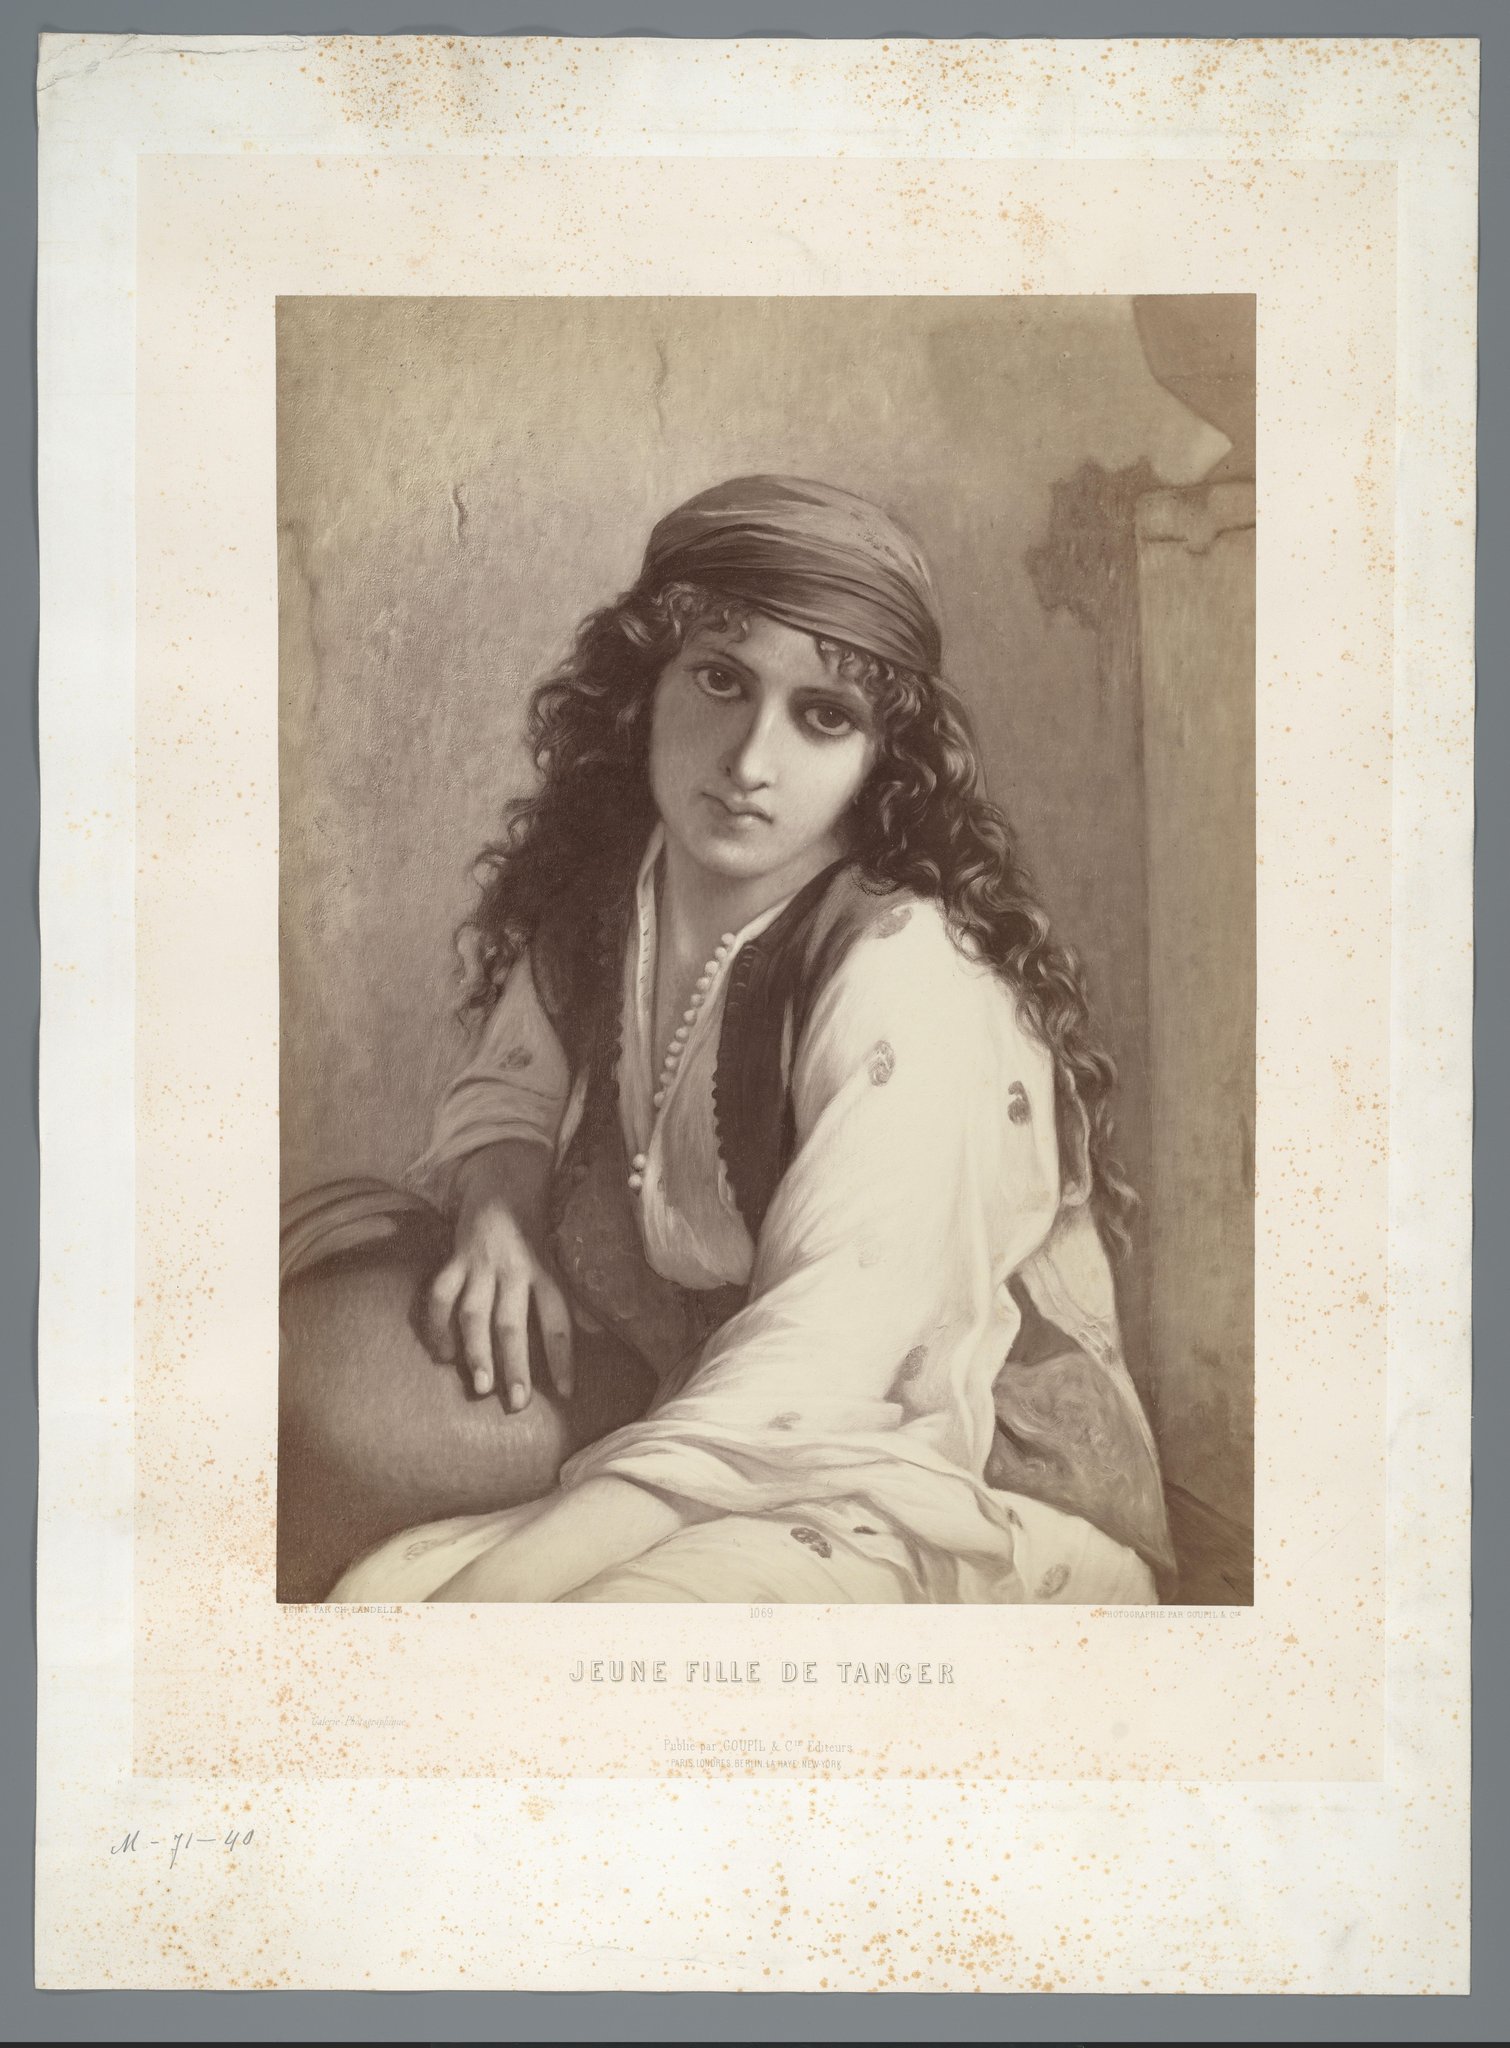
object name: reproduction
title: Fotoreproductie van het schilderij Jeune fille de Tanger door Charles Landelle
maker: charles landelle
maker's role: painter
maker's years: 1821-1908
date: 1870-1884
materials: cardboard, paper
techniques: albumen print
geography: paris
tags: adolescent, young woman, maiden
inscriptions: inscription: ‘M-71-40’, number: ‘1069’